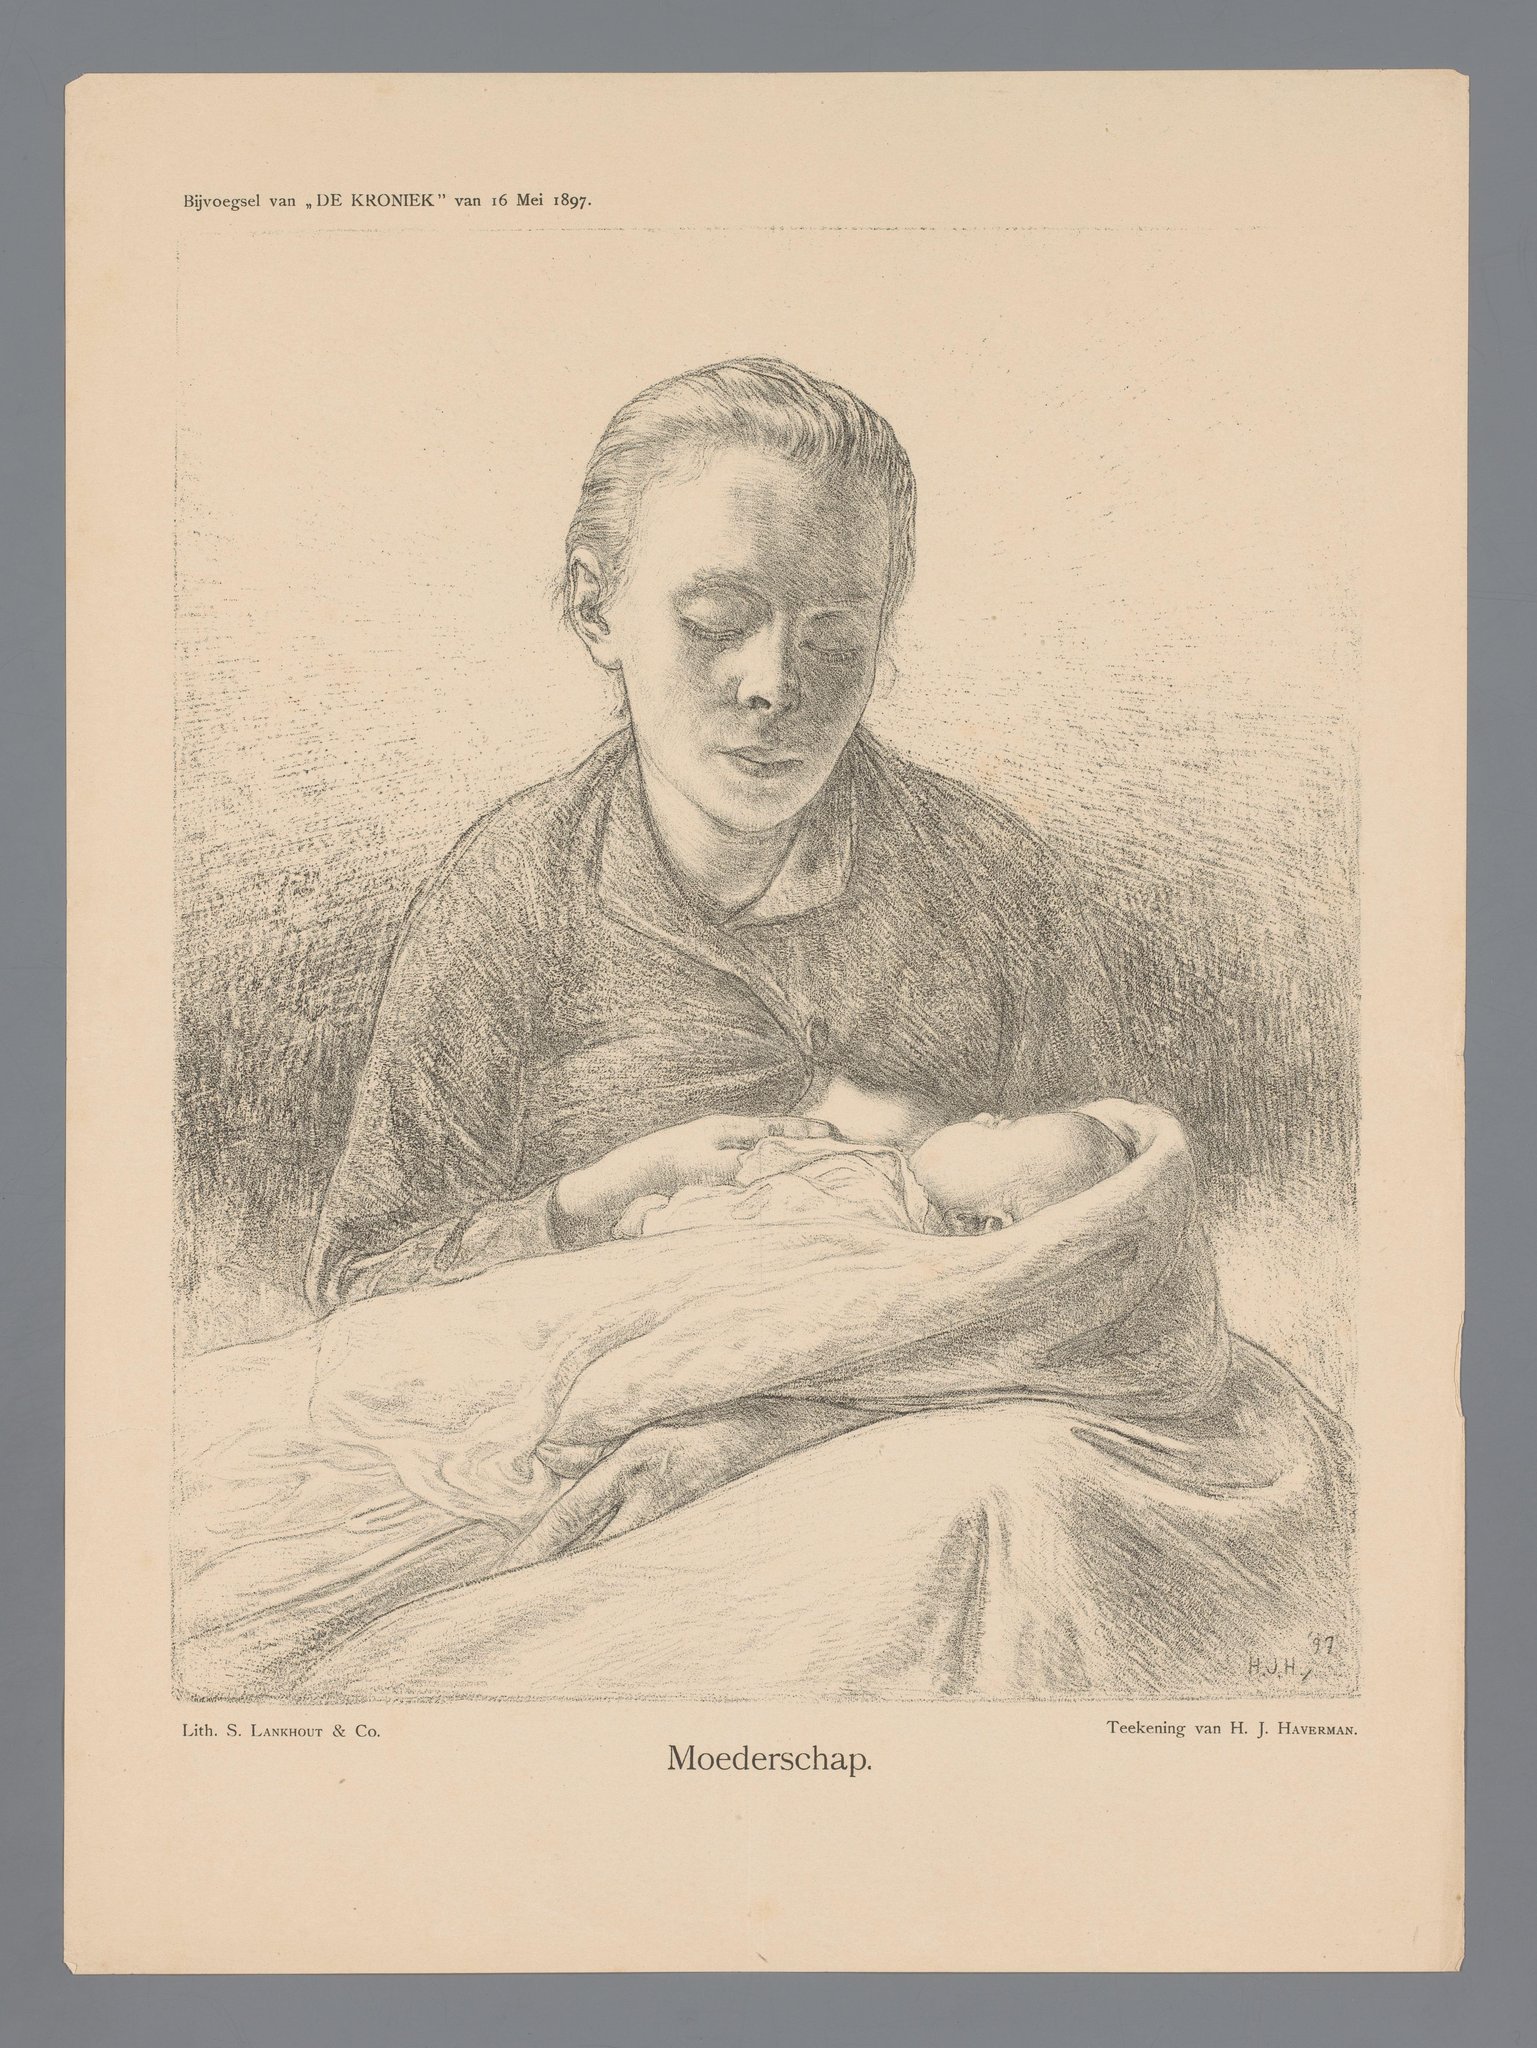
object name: print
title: Moederschap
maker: hendrik johannes haverman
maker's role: draughtsman, print maker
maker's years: 1857-1928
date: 1897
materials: paper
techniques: lithograph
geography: the hague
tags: nursing, suckling, netherlands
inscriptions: date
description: Prent met titel en onderschrift, bijvoegsel bij 'De Kroniek'. Gesigneerd en gedateerd.